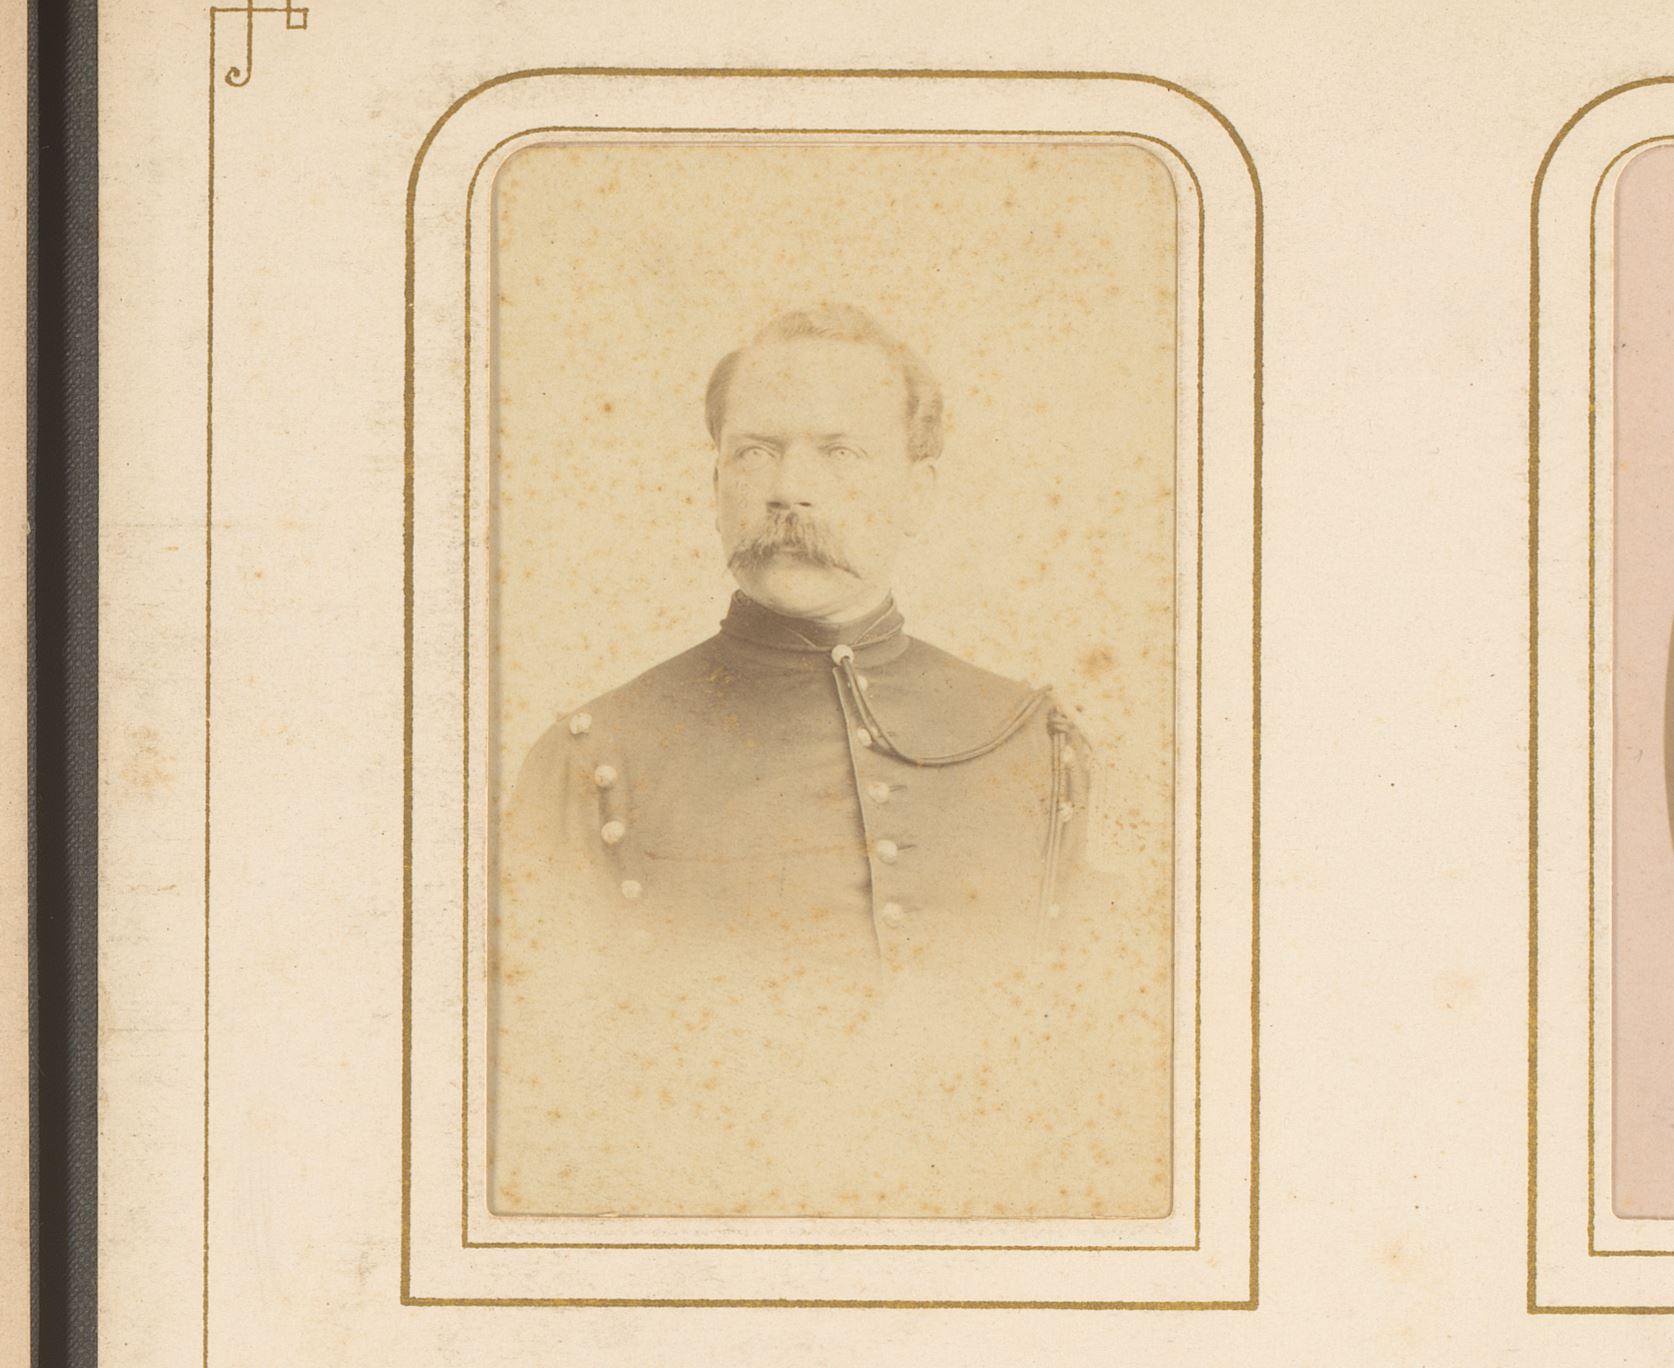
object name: photograph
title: Portret van een man met snor in uniform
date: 1863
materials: cardboard, photographic support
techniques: albumen print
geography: brussels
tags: moustache, historical persons, (military) uniforms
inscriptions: inscription: ‘PHOTOGRAPHIE/ DE/ BARON & MITKIEWICZ/ 9, RUE NEUVE, 9/ Bruxelles’